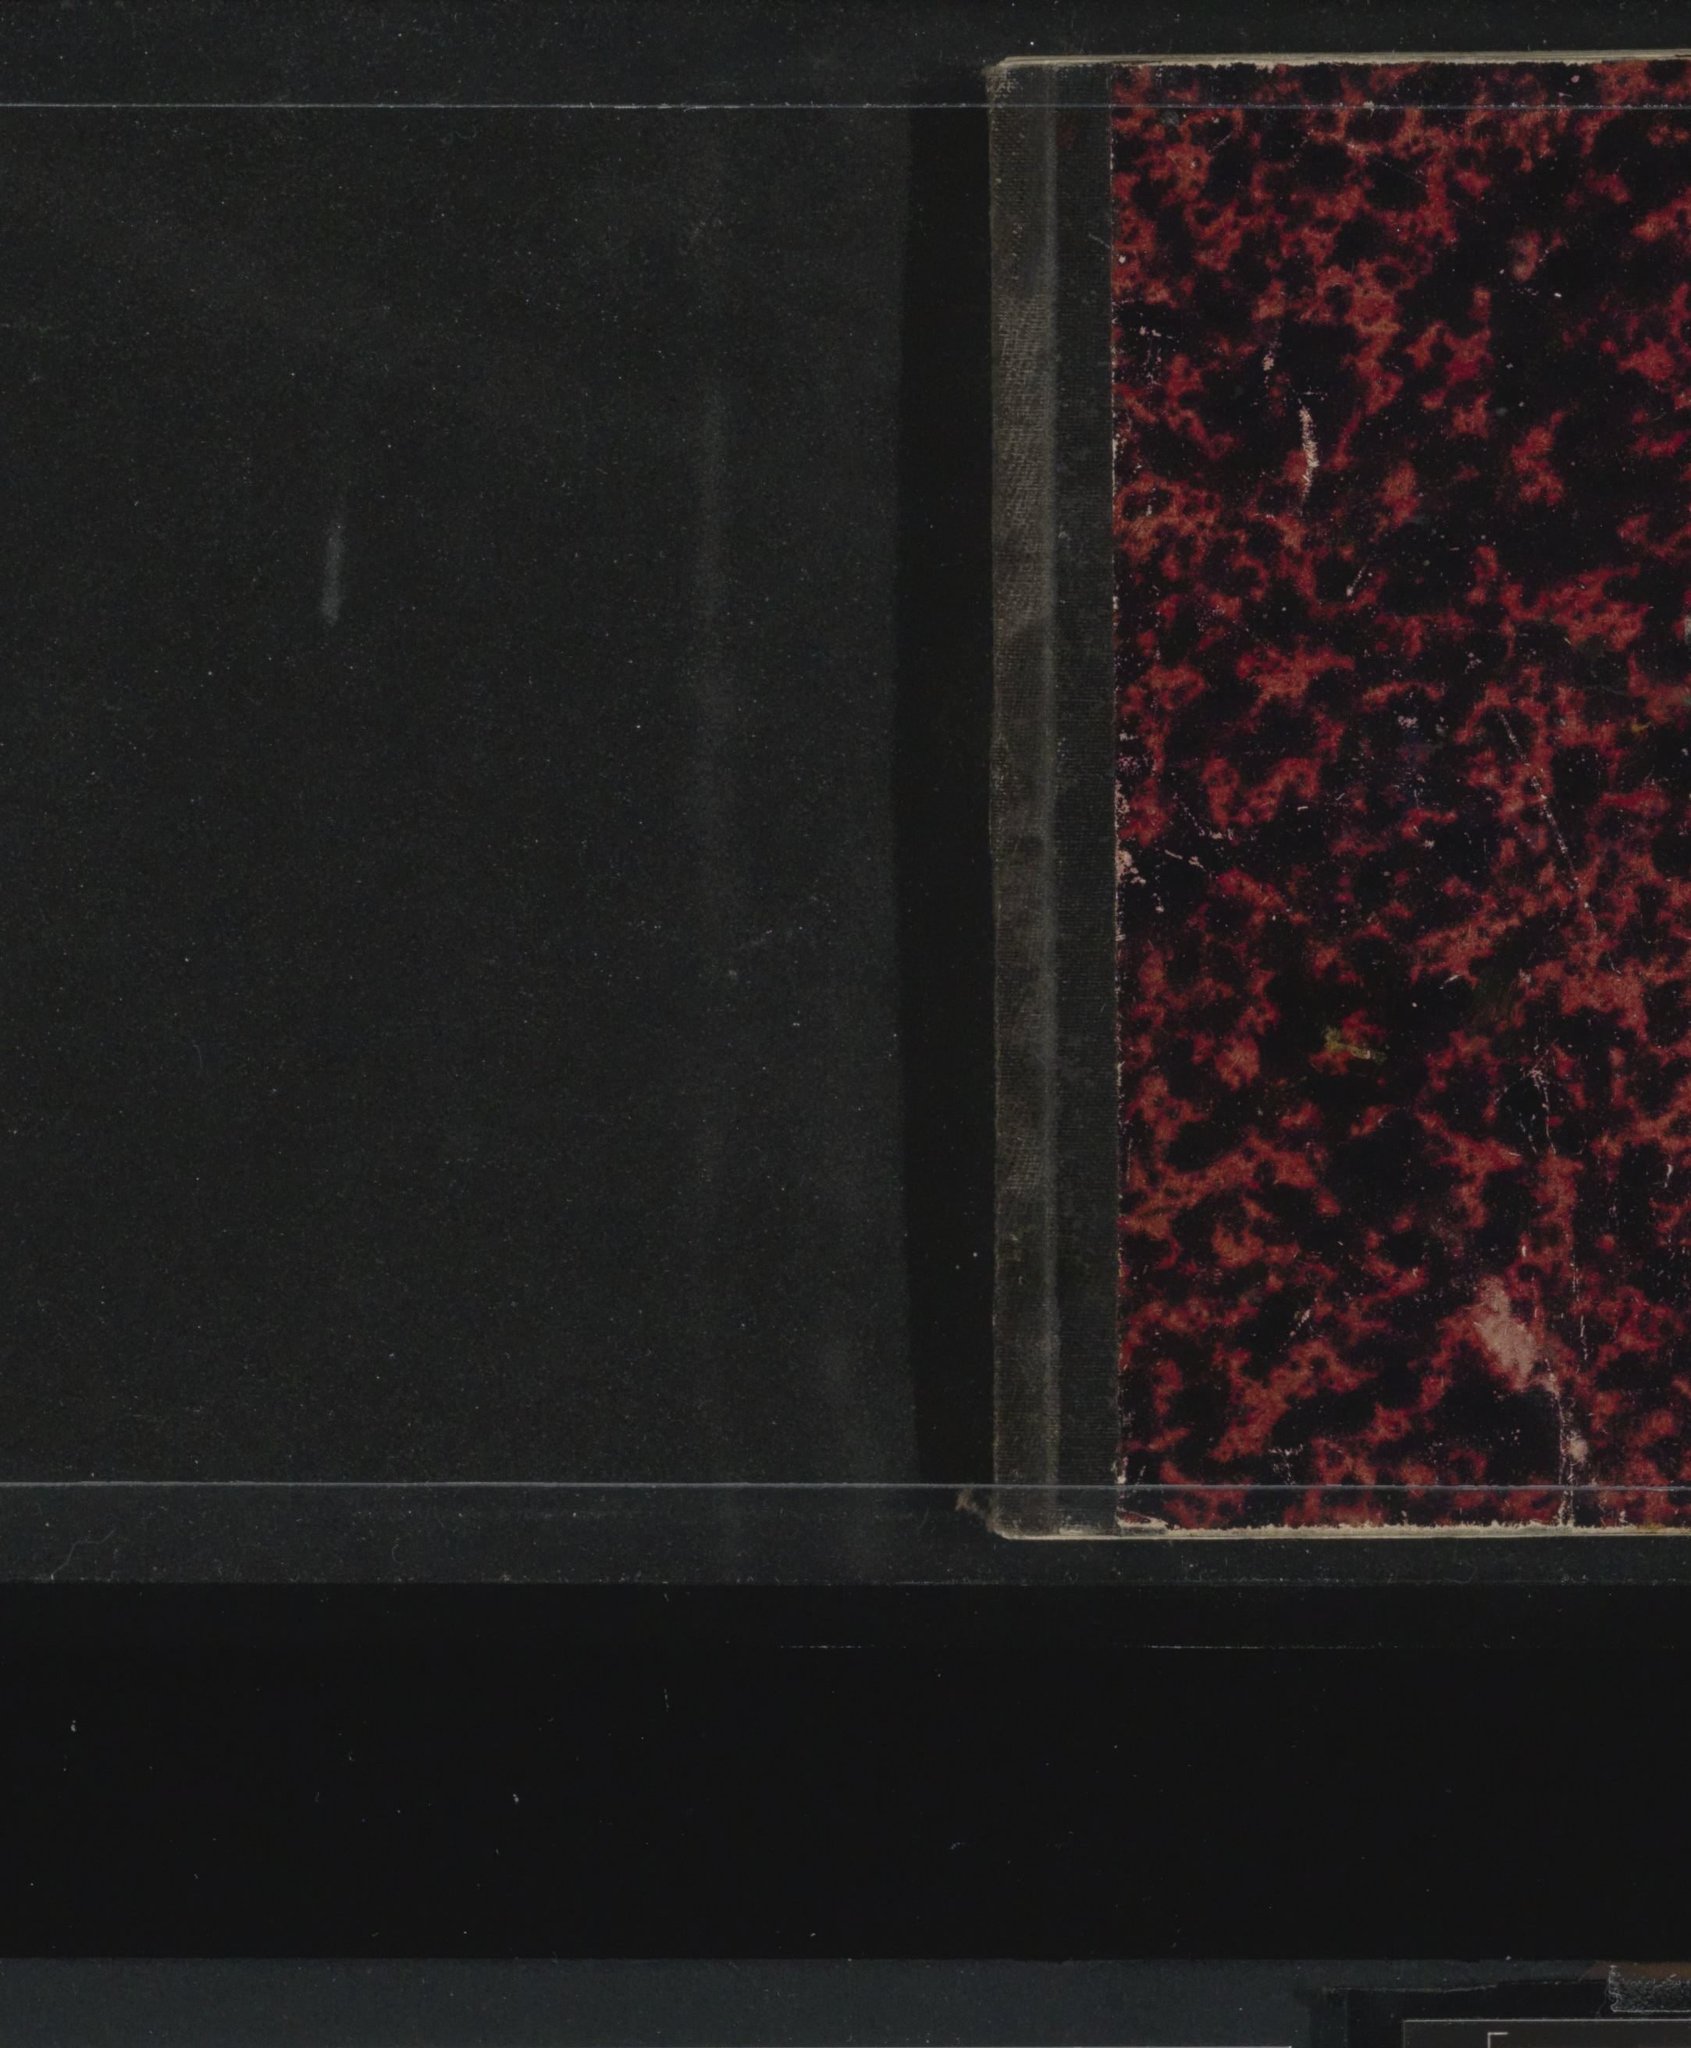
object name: sketchbook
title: Schetsboek XXXII met 92 pagina's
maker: isaac israels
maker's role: draughtsman, painter, print maker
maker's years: 1865-1934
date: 1886-1903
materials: cardboard, chalk, linen, paper, pencil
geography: amsterdam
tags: head (human) - aa - female human figure, street (+ city(-scape) with figures, staffage)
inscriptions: collector's mark: Lugt 2228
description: Pagina's 2, 4 t/m 13, 16, 17, 20 t/m 23, 28, 29, 34, 35, 56, 57, 62 t/m 77, 82 t/m 85 en 88 t/m 91 zijn blanco en daarom niet beschreven.